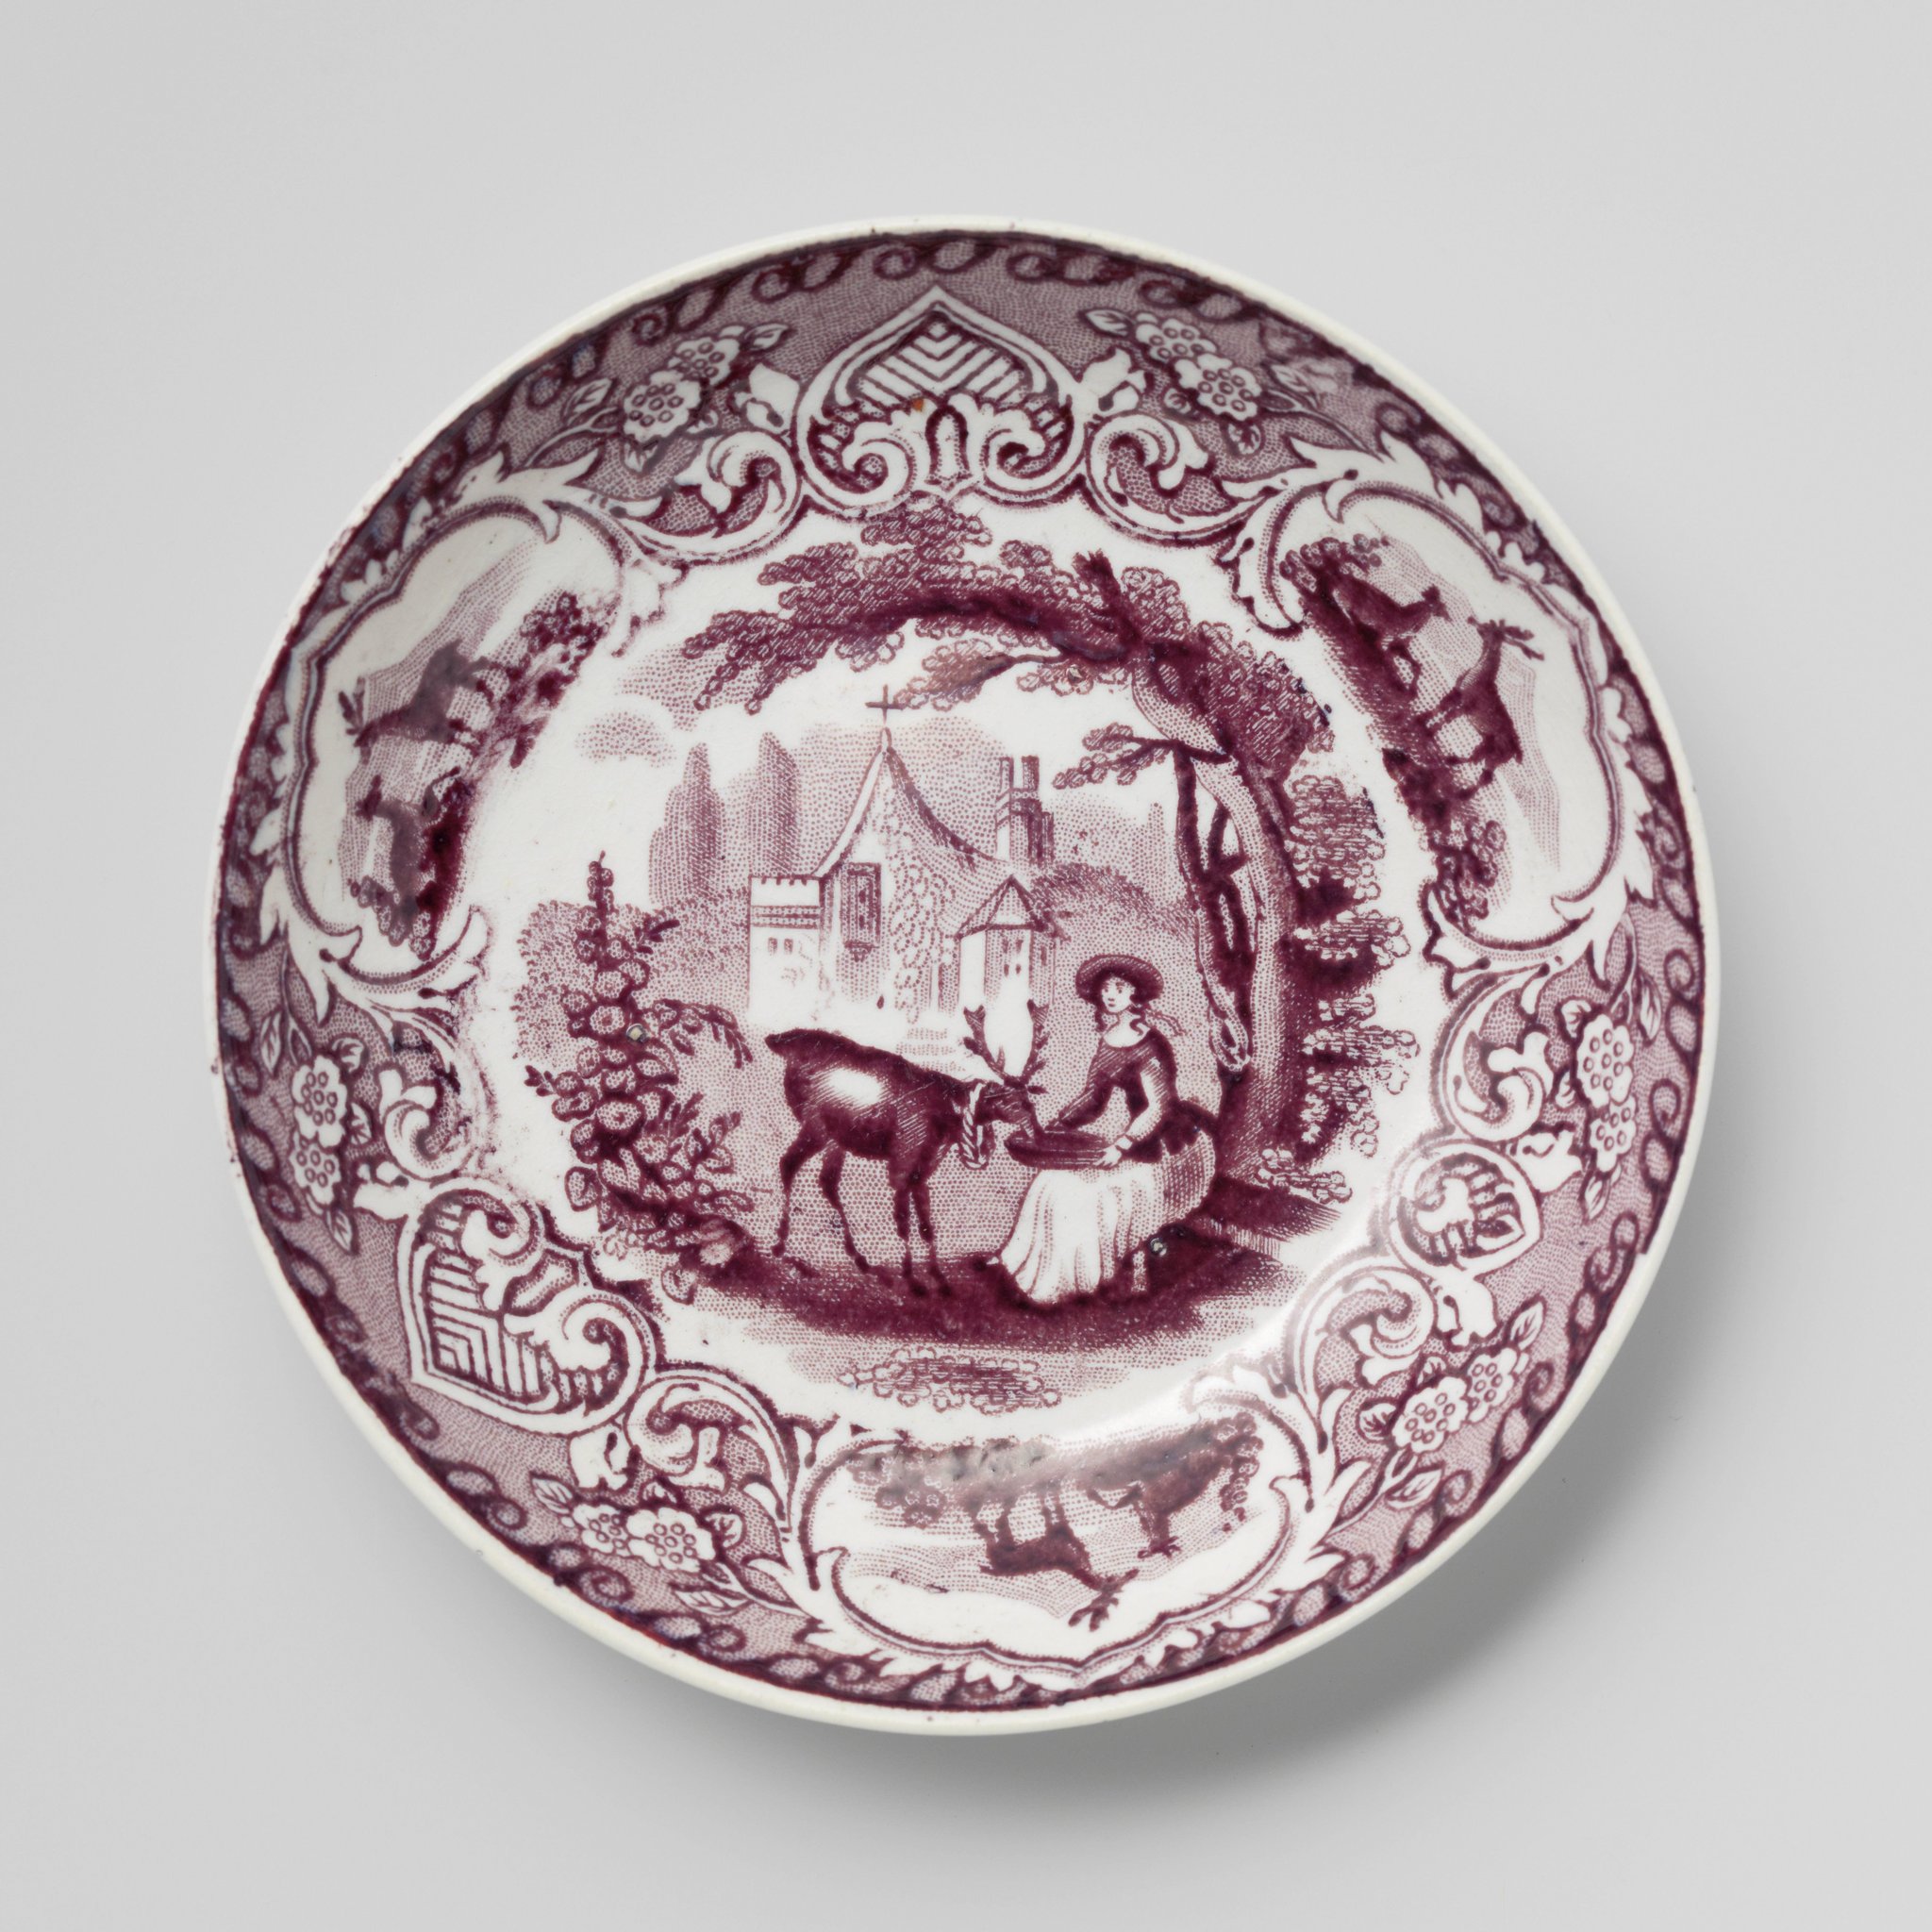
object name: platter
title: Schotel met op het plat een vrouw die een hert voert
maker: petrus regout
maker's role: plateelbakker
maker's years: 1801-1879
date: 1801-1879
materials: earthenware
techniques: transfer decoration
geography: maastricht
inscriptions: check stamp: ‘PETRUS REGOUT // 5 // MAASTRICHT’, mark: ‘THE STAG // MAASTRICHT // PETRUS REGOUT’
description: Schotel van aardewerk met een paars transferdecor. Op het plat een voorstelling van een vrouw die een hert voert. Op de rand van de schotel drie cartouches met herten.